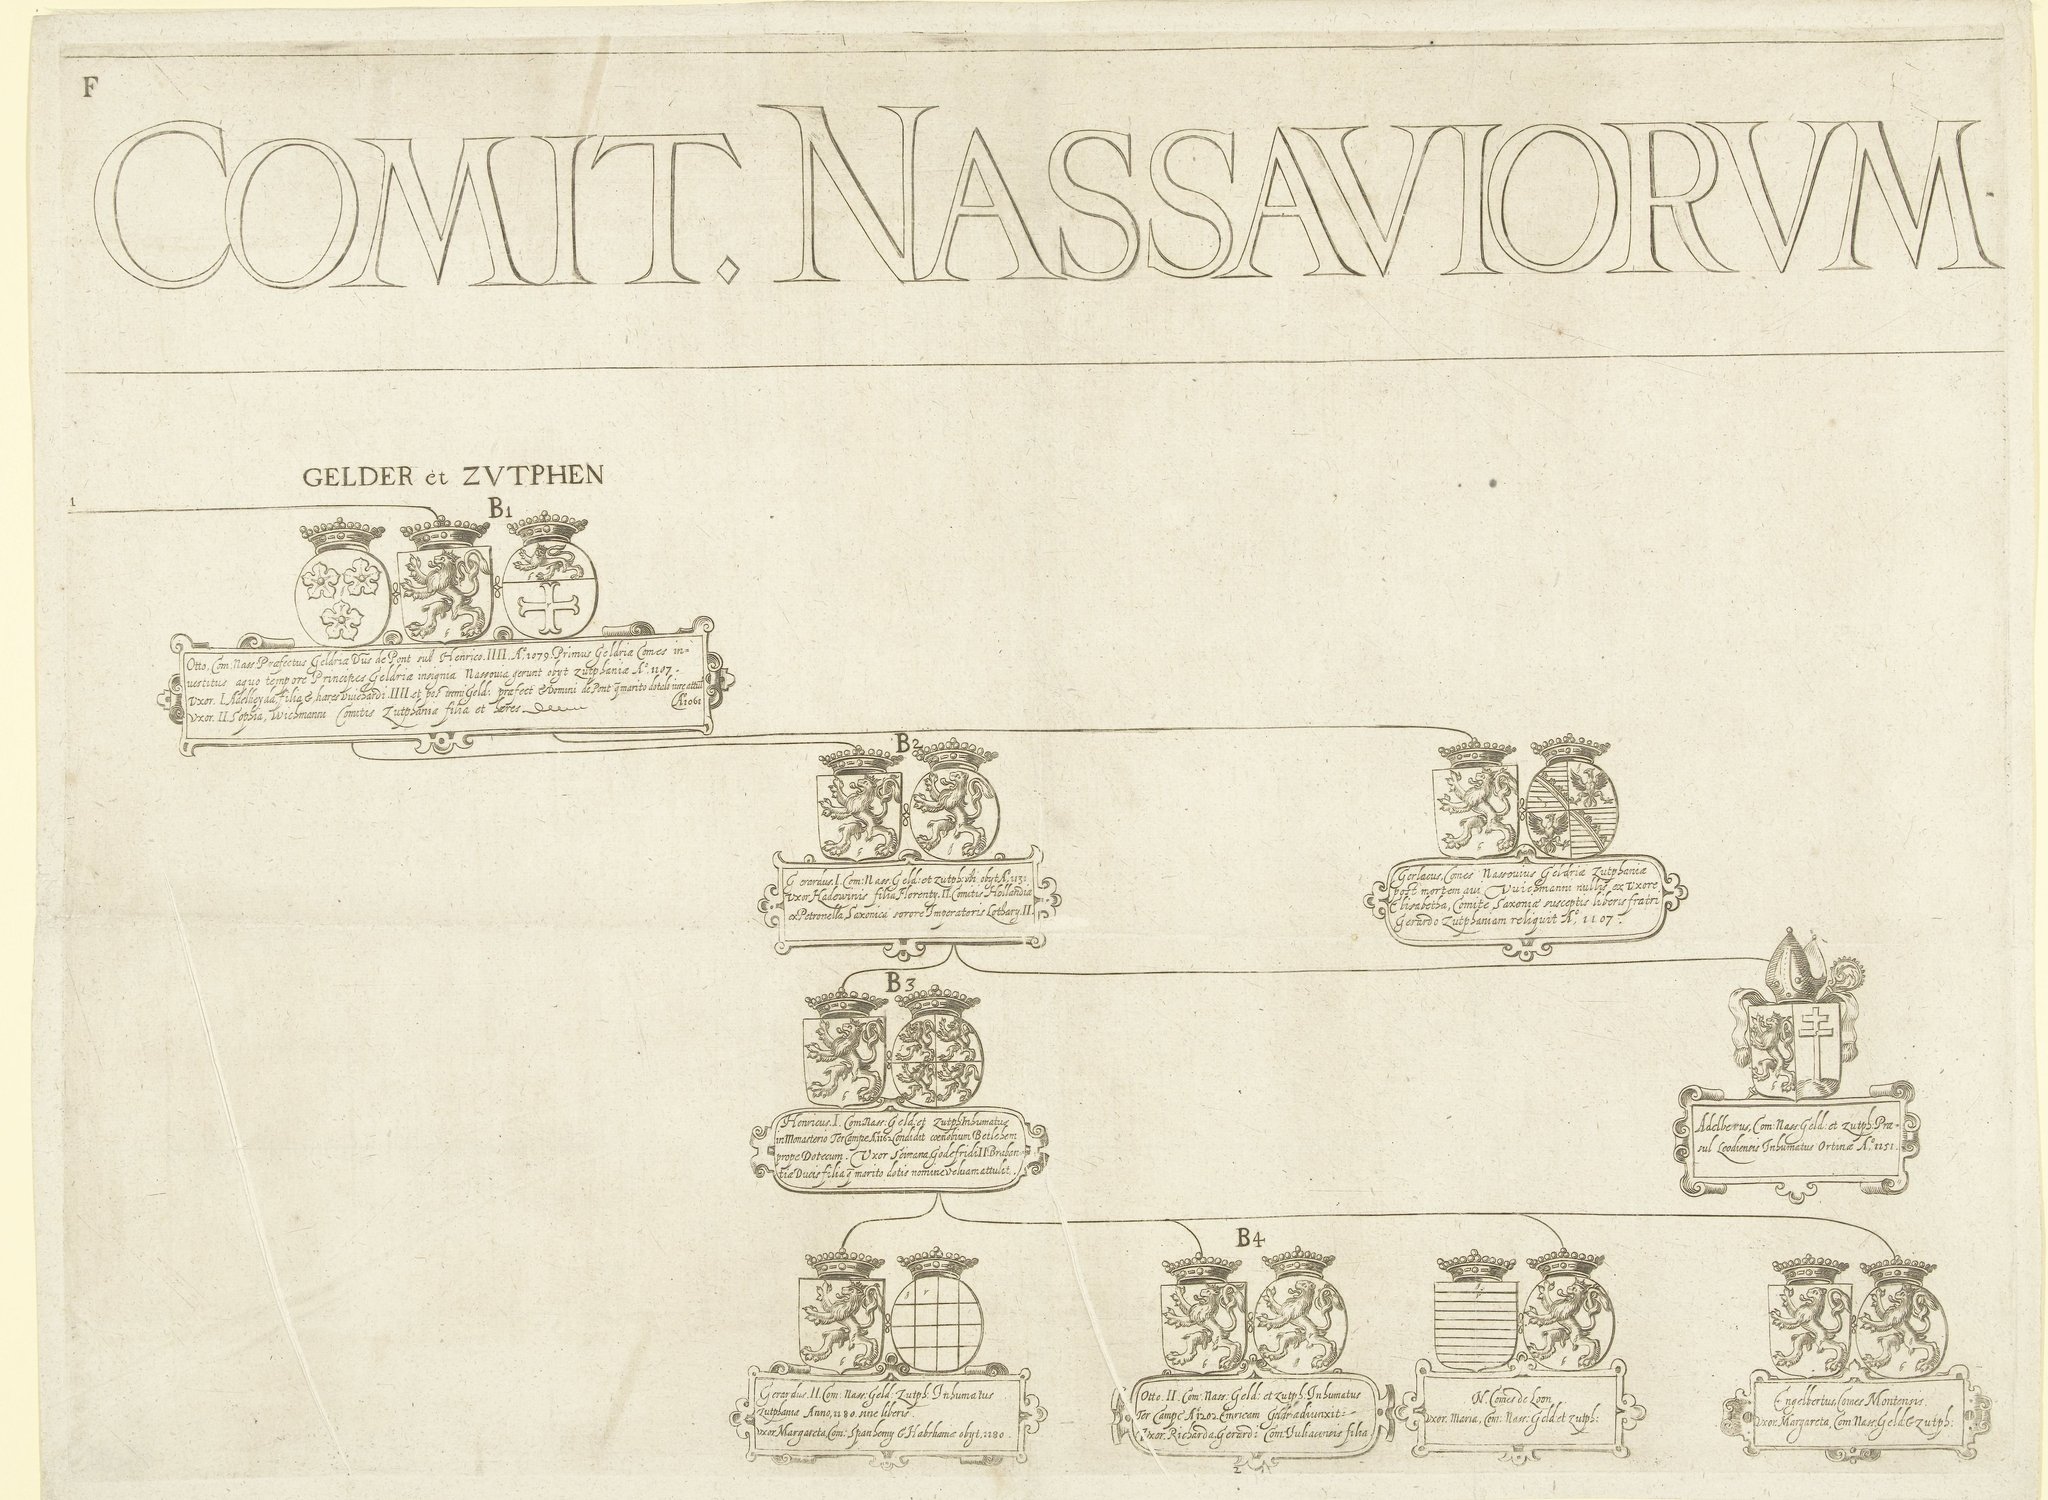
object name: print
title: Genealogie van de graven van Nassau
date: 1612-1619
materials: paper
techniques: engraving, etching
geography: low countries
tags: family lineage, pedigree, genealogical tree or table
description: Stamboom van het Huis Nassau, van 972 tot en met 1612, blad F in een reeks van zeven bladen gemerkt A-G. Meerdere wapens met in cirkels en cartouches namen, titels en jaartallen. Midden boven een deel van een regel Latijnse tekst.